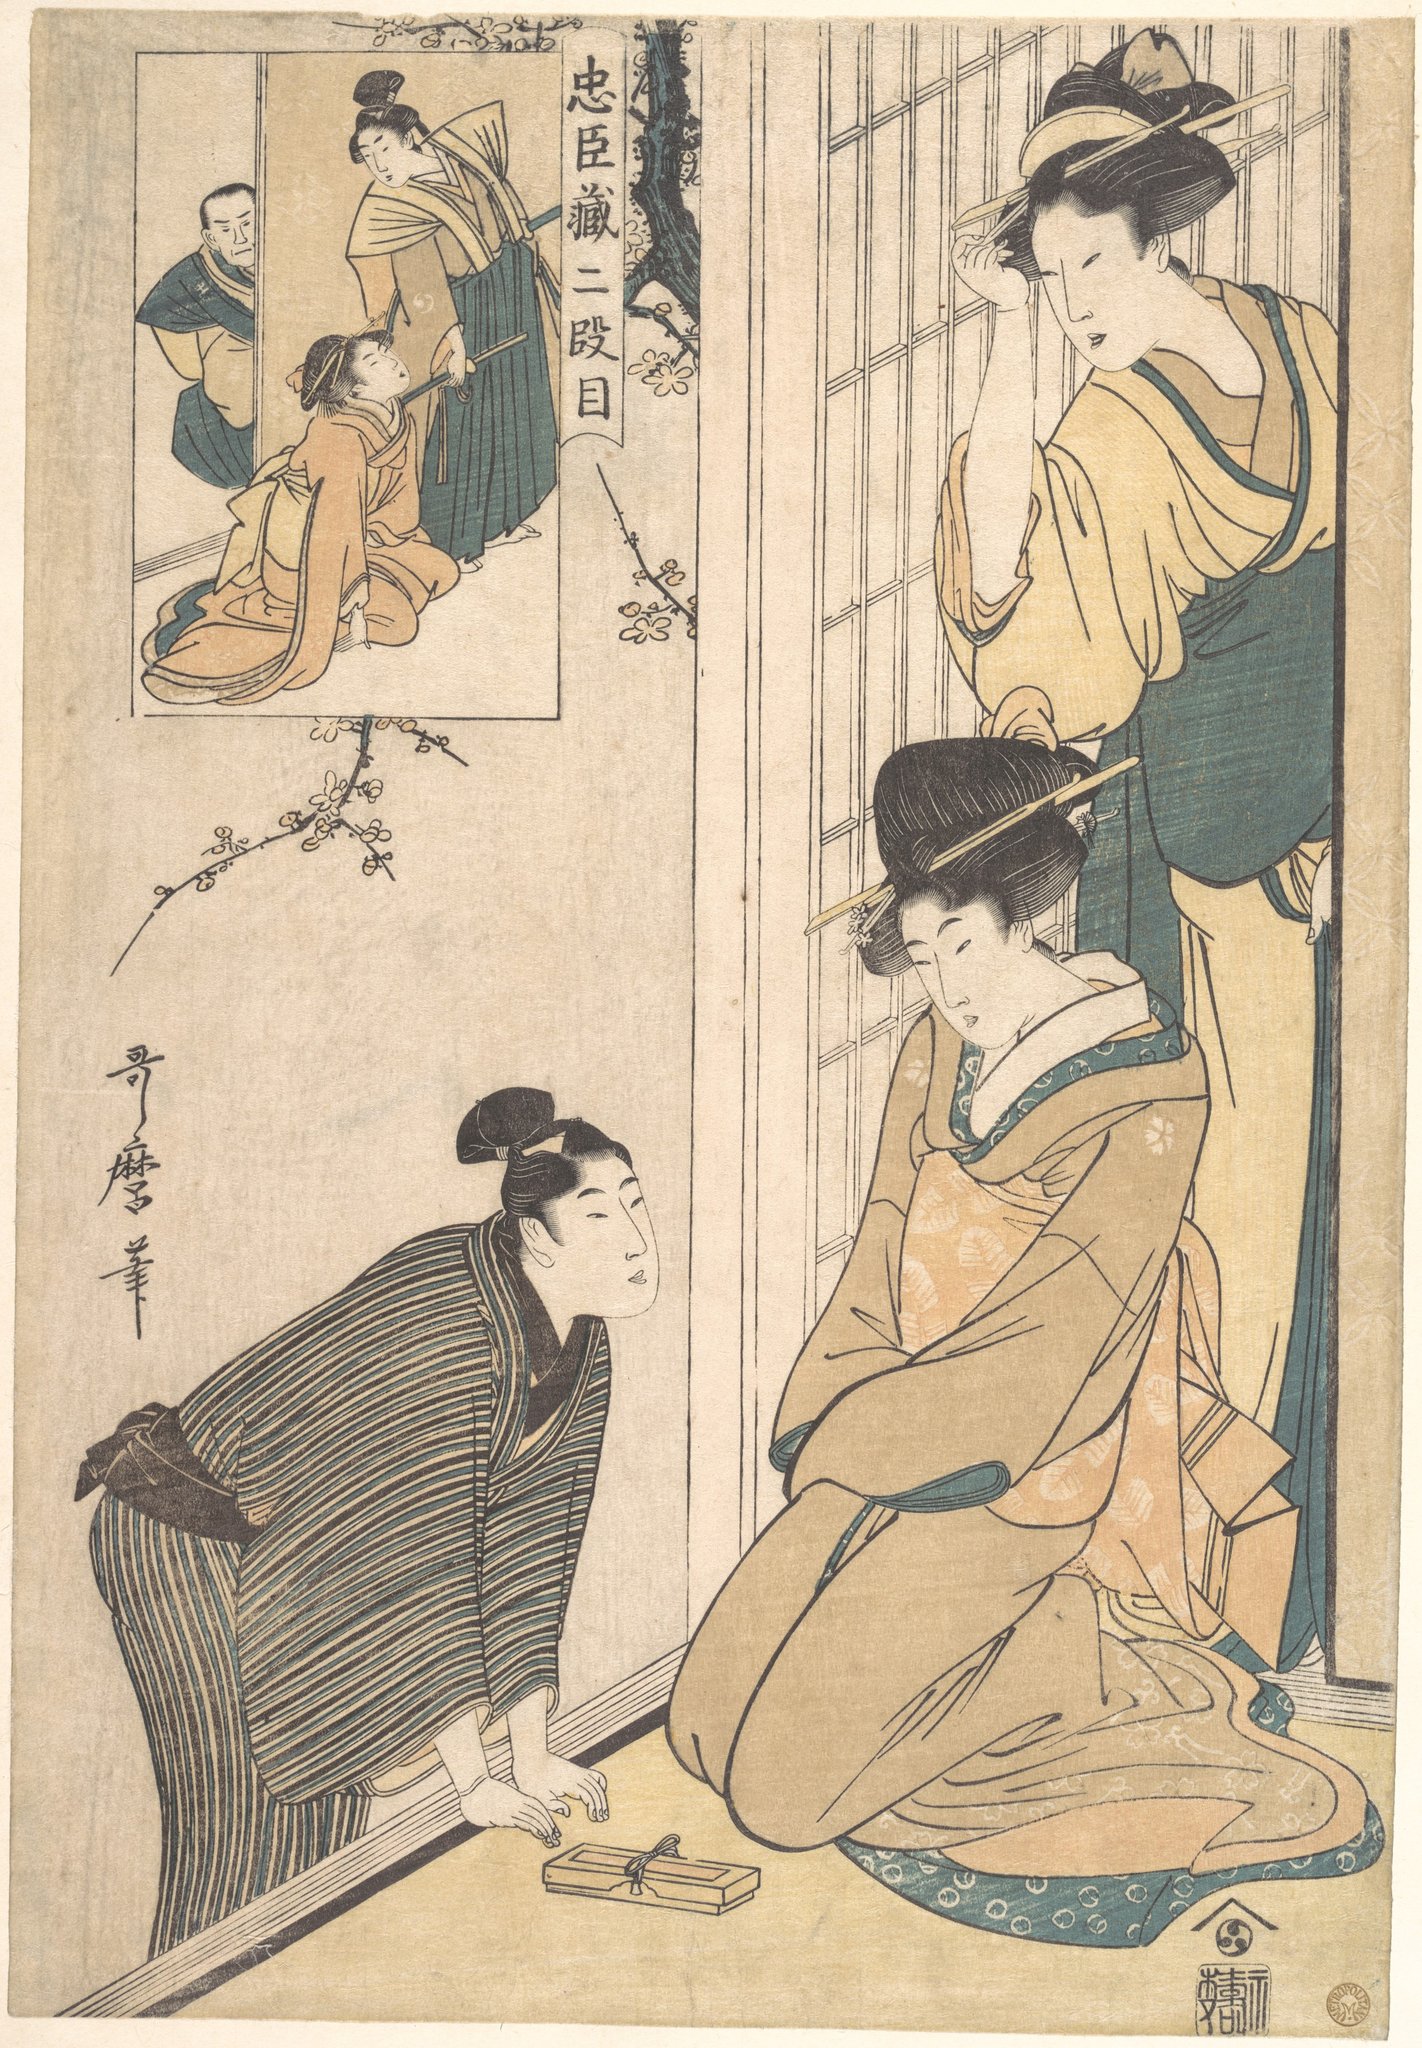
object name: print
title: A Young Man at the Side of a House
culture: japanese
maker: kitagawa utamaro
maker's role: artist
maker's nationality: japanese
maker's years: 1754-1806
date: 1754-1806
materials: ink, paper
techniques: woodblock print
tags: men,women